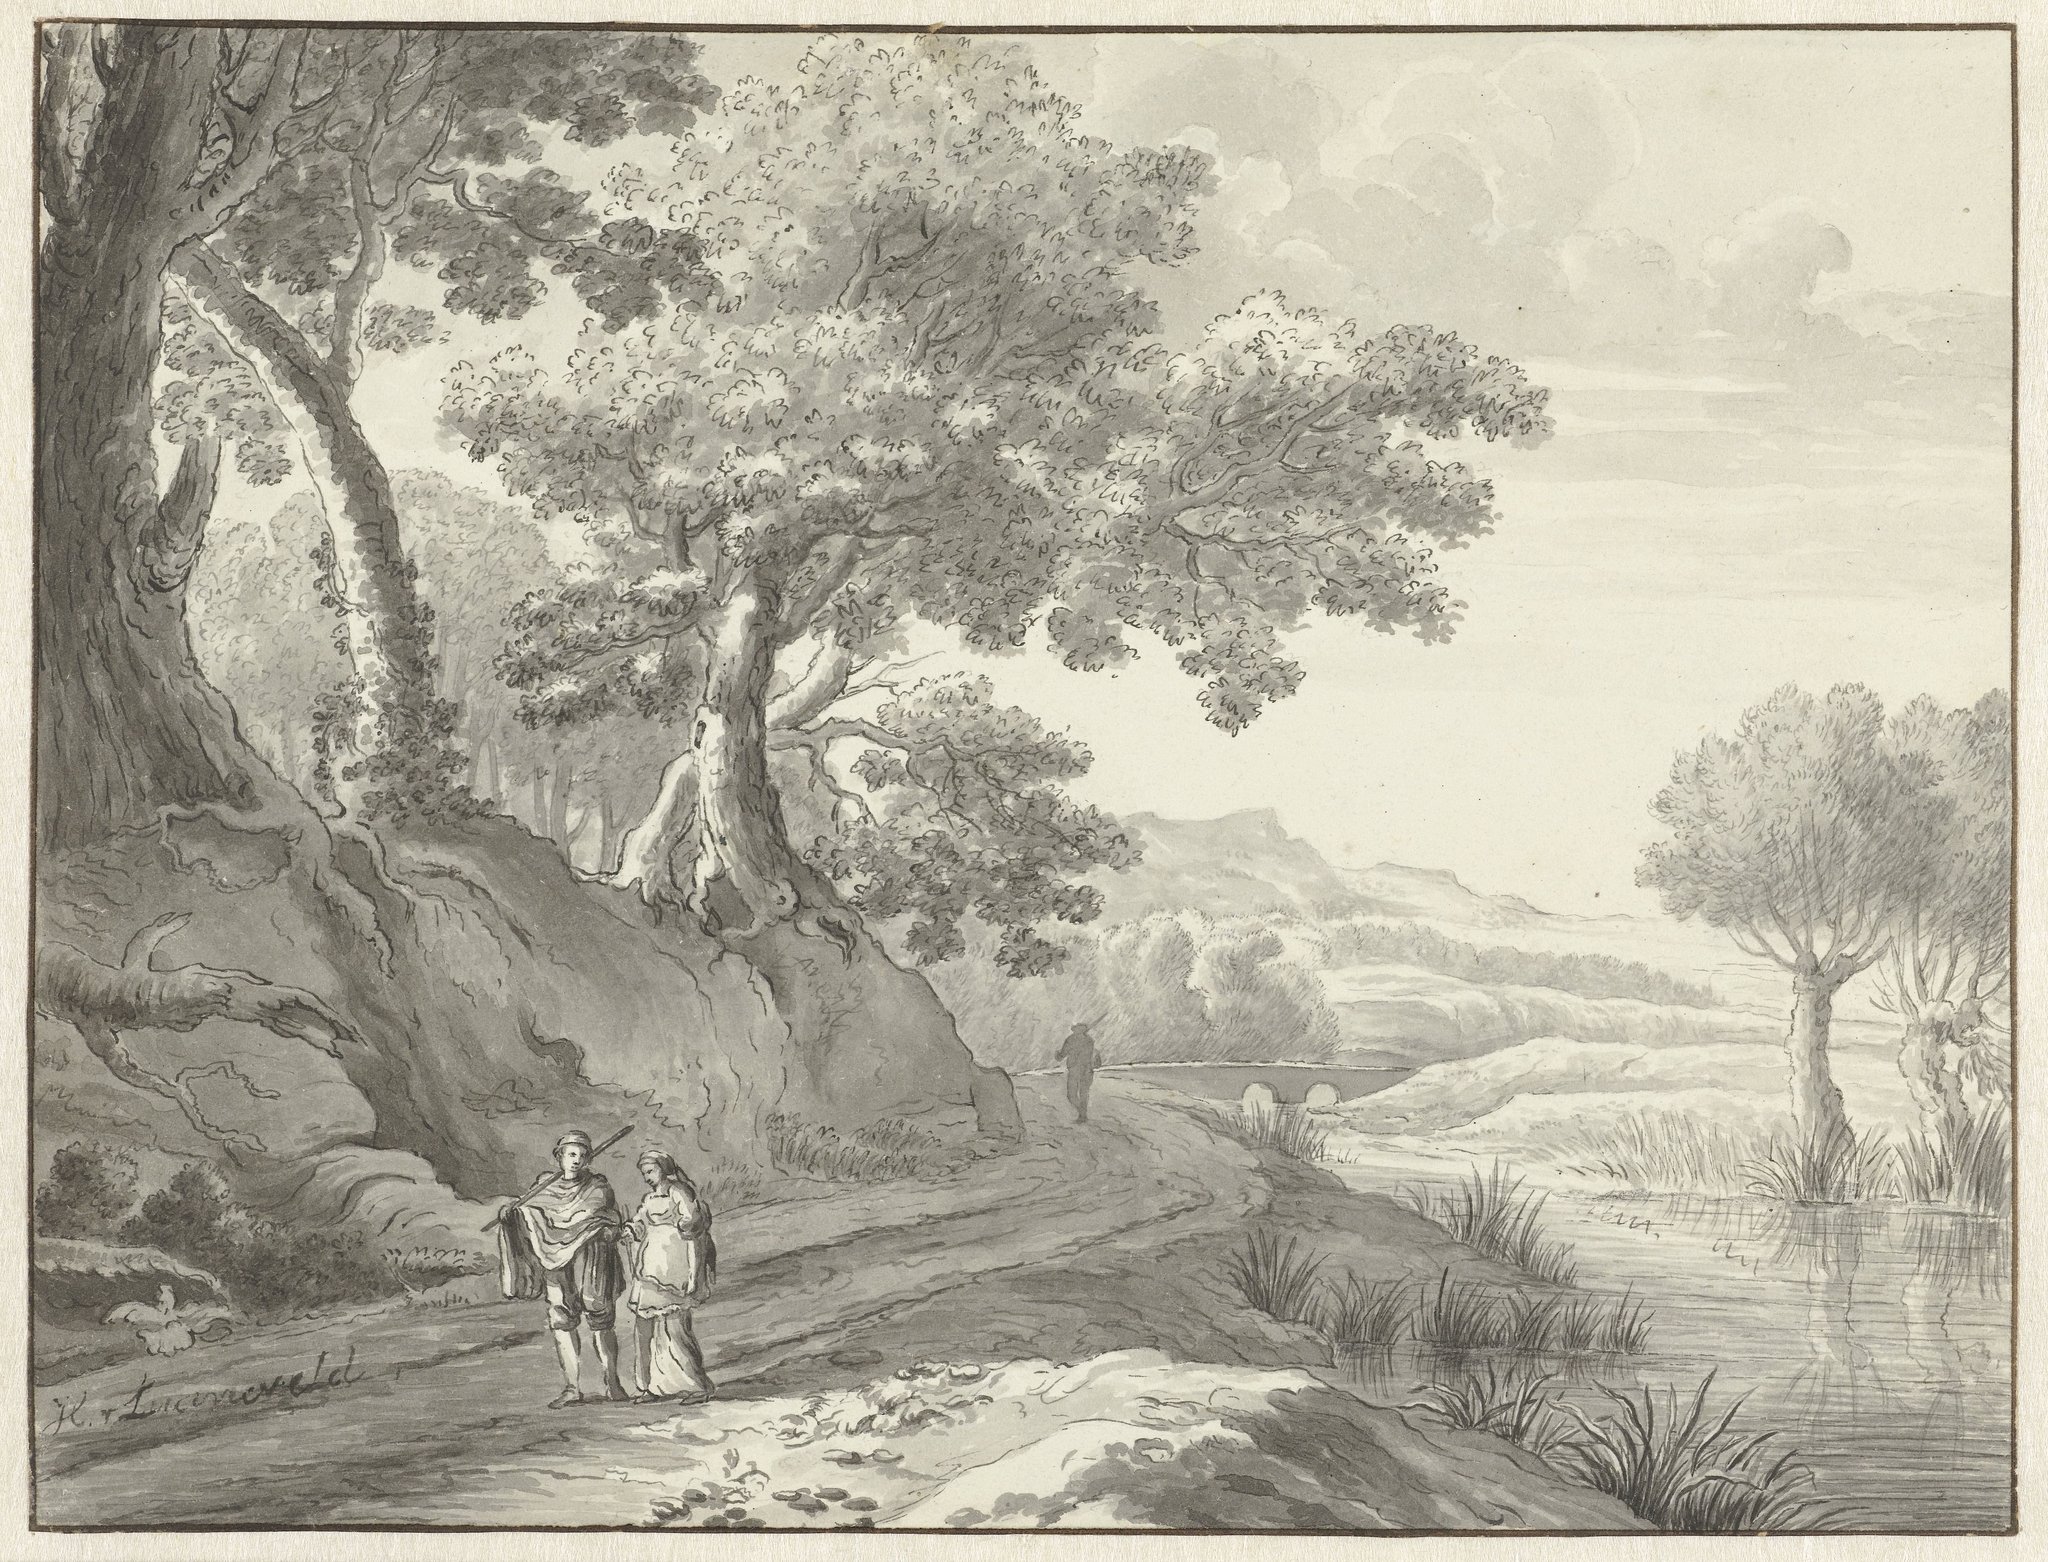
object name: drawing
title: Landschap met wandelaars op een weg langs water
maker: Anonymous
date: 1610-1705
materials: ink, paper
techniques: brush, pen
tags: landscapes with waters, waterscapes, seascapes (in the temperate zone), mountains